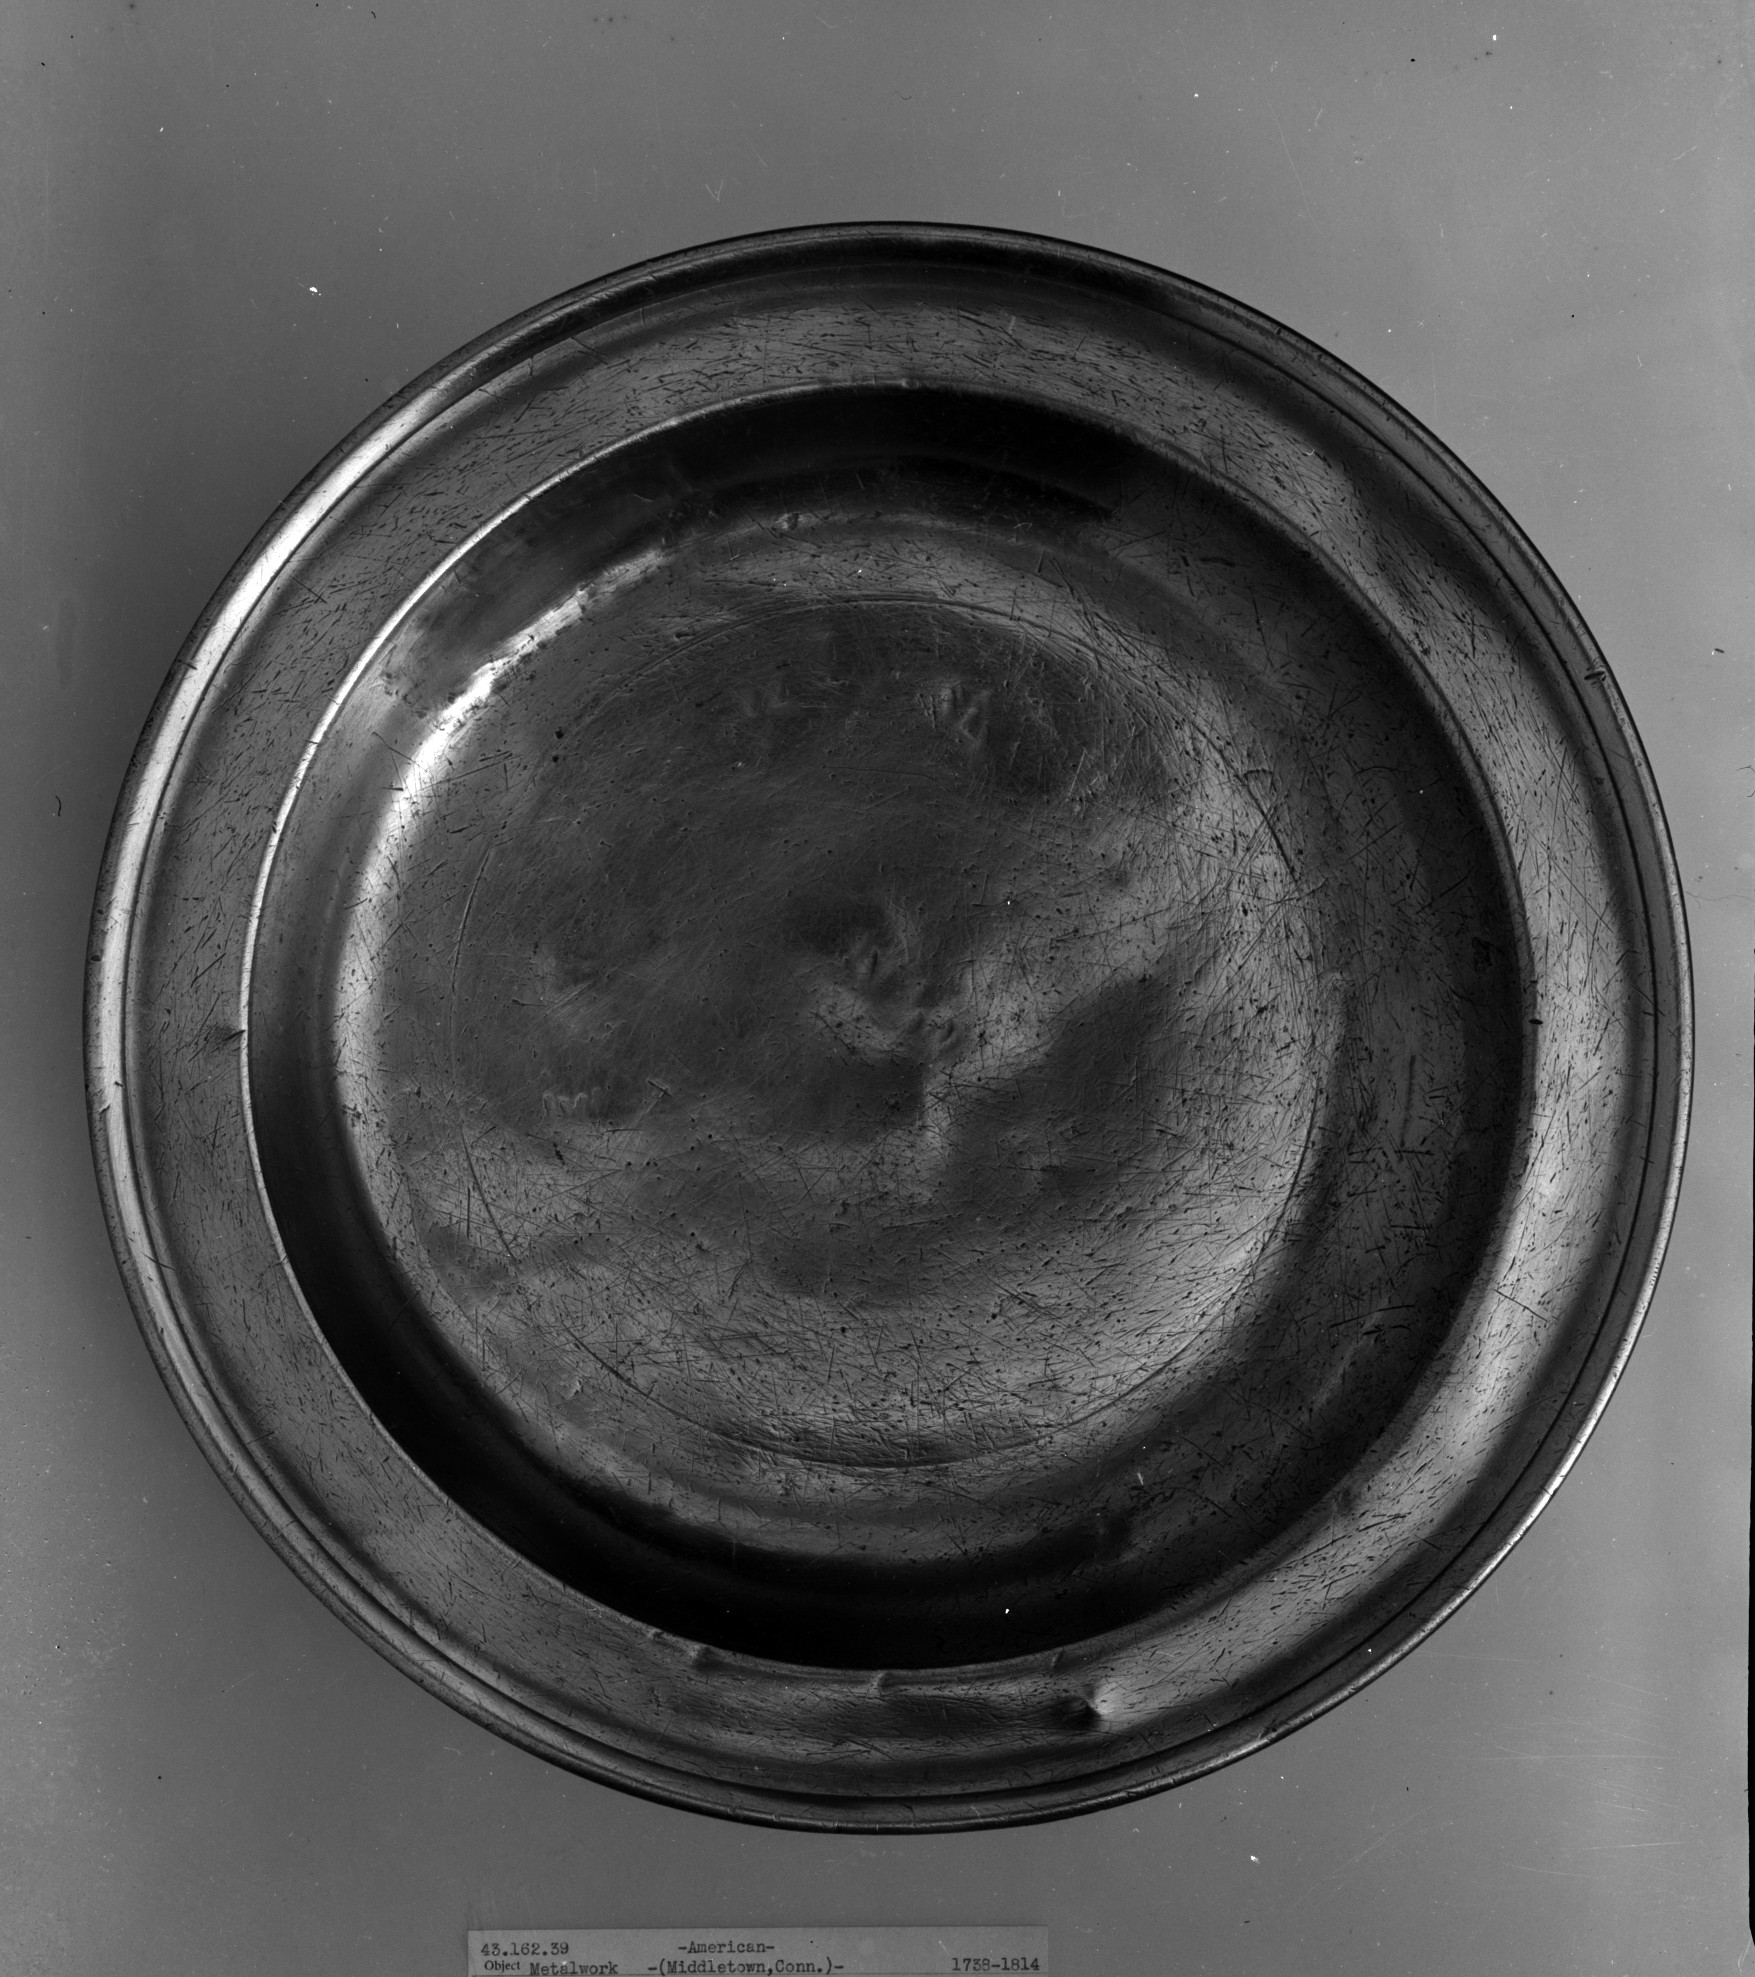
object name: dish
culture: american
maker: amos treadway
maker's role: maker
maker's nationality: american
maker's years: 1738-1814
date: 1760-1808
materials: pewter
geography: united states